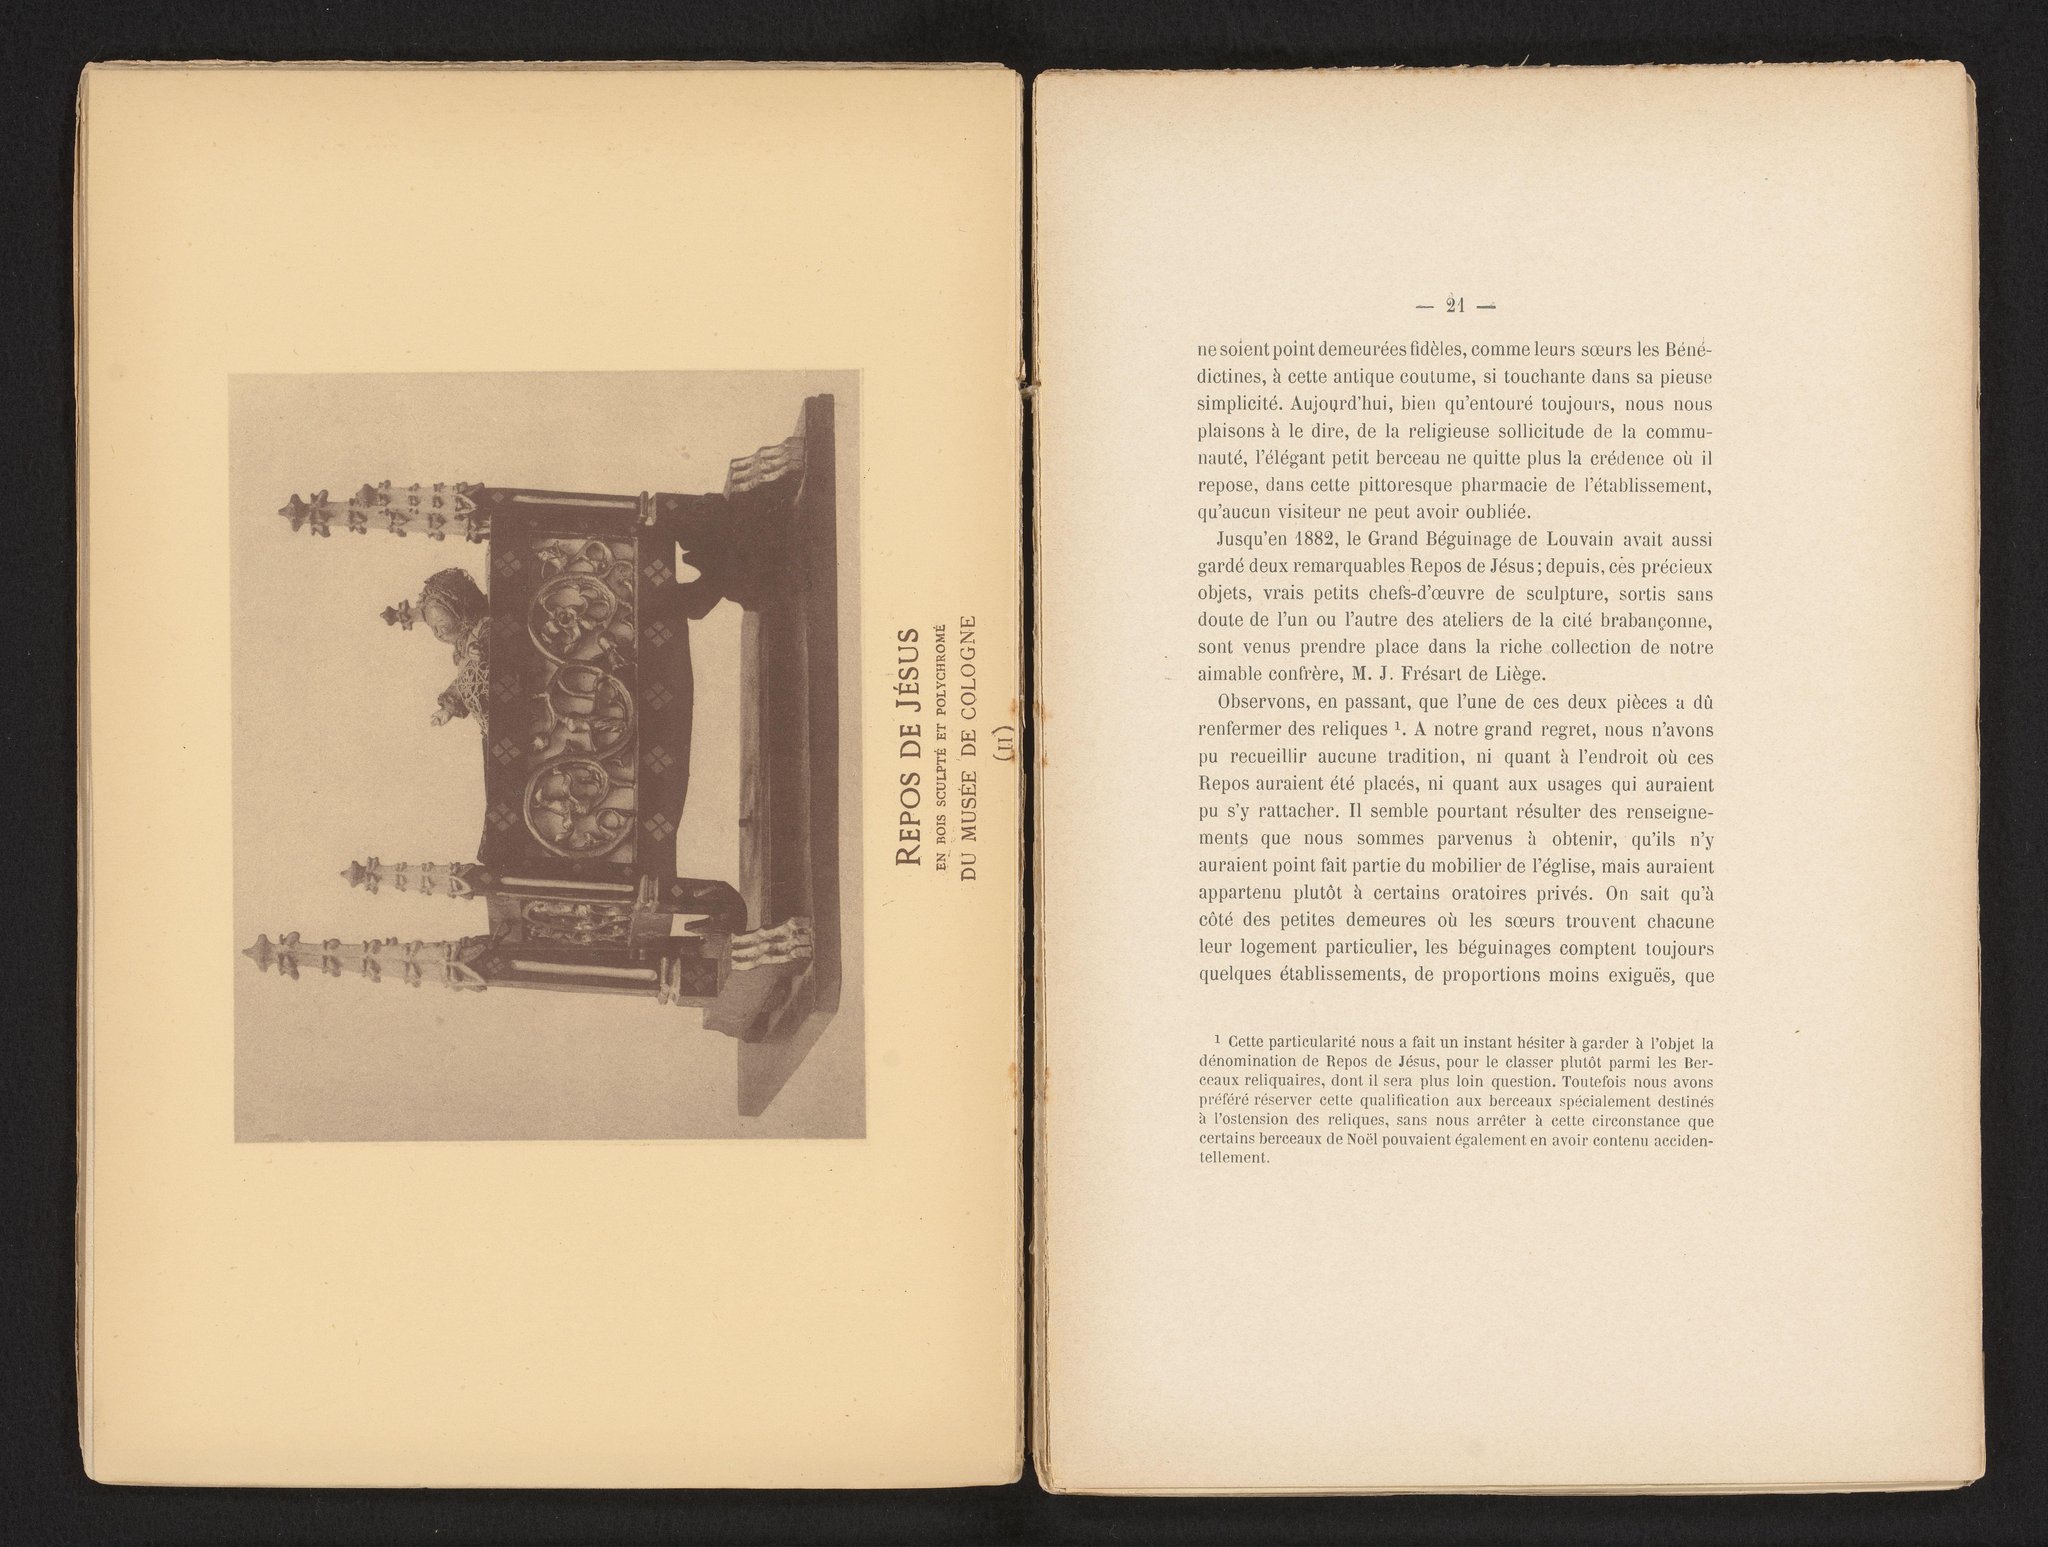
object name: page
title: Reliekhouder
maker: Anonymous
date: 1885-1890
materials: paper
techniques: photograph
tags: relics (and reliquaries)